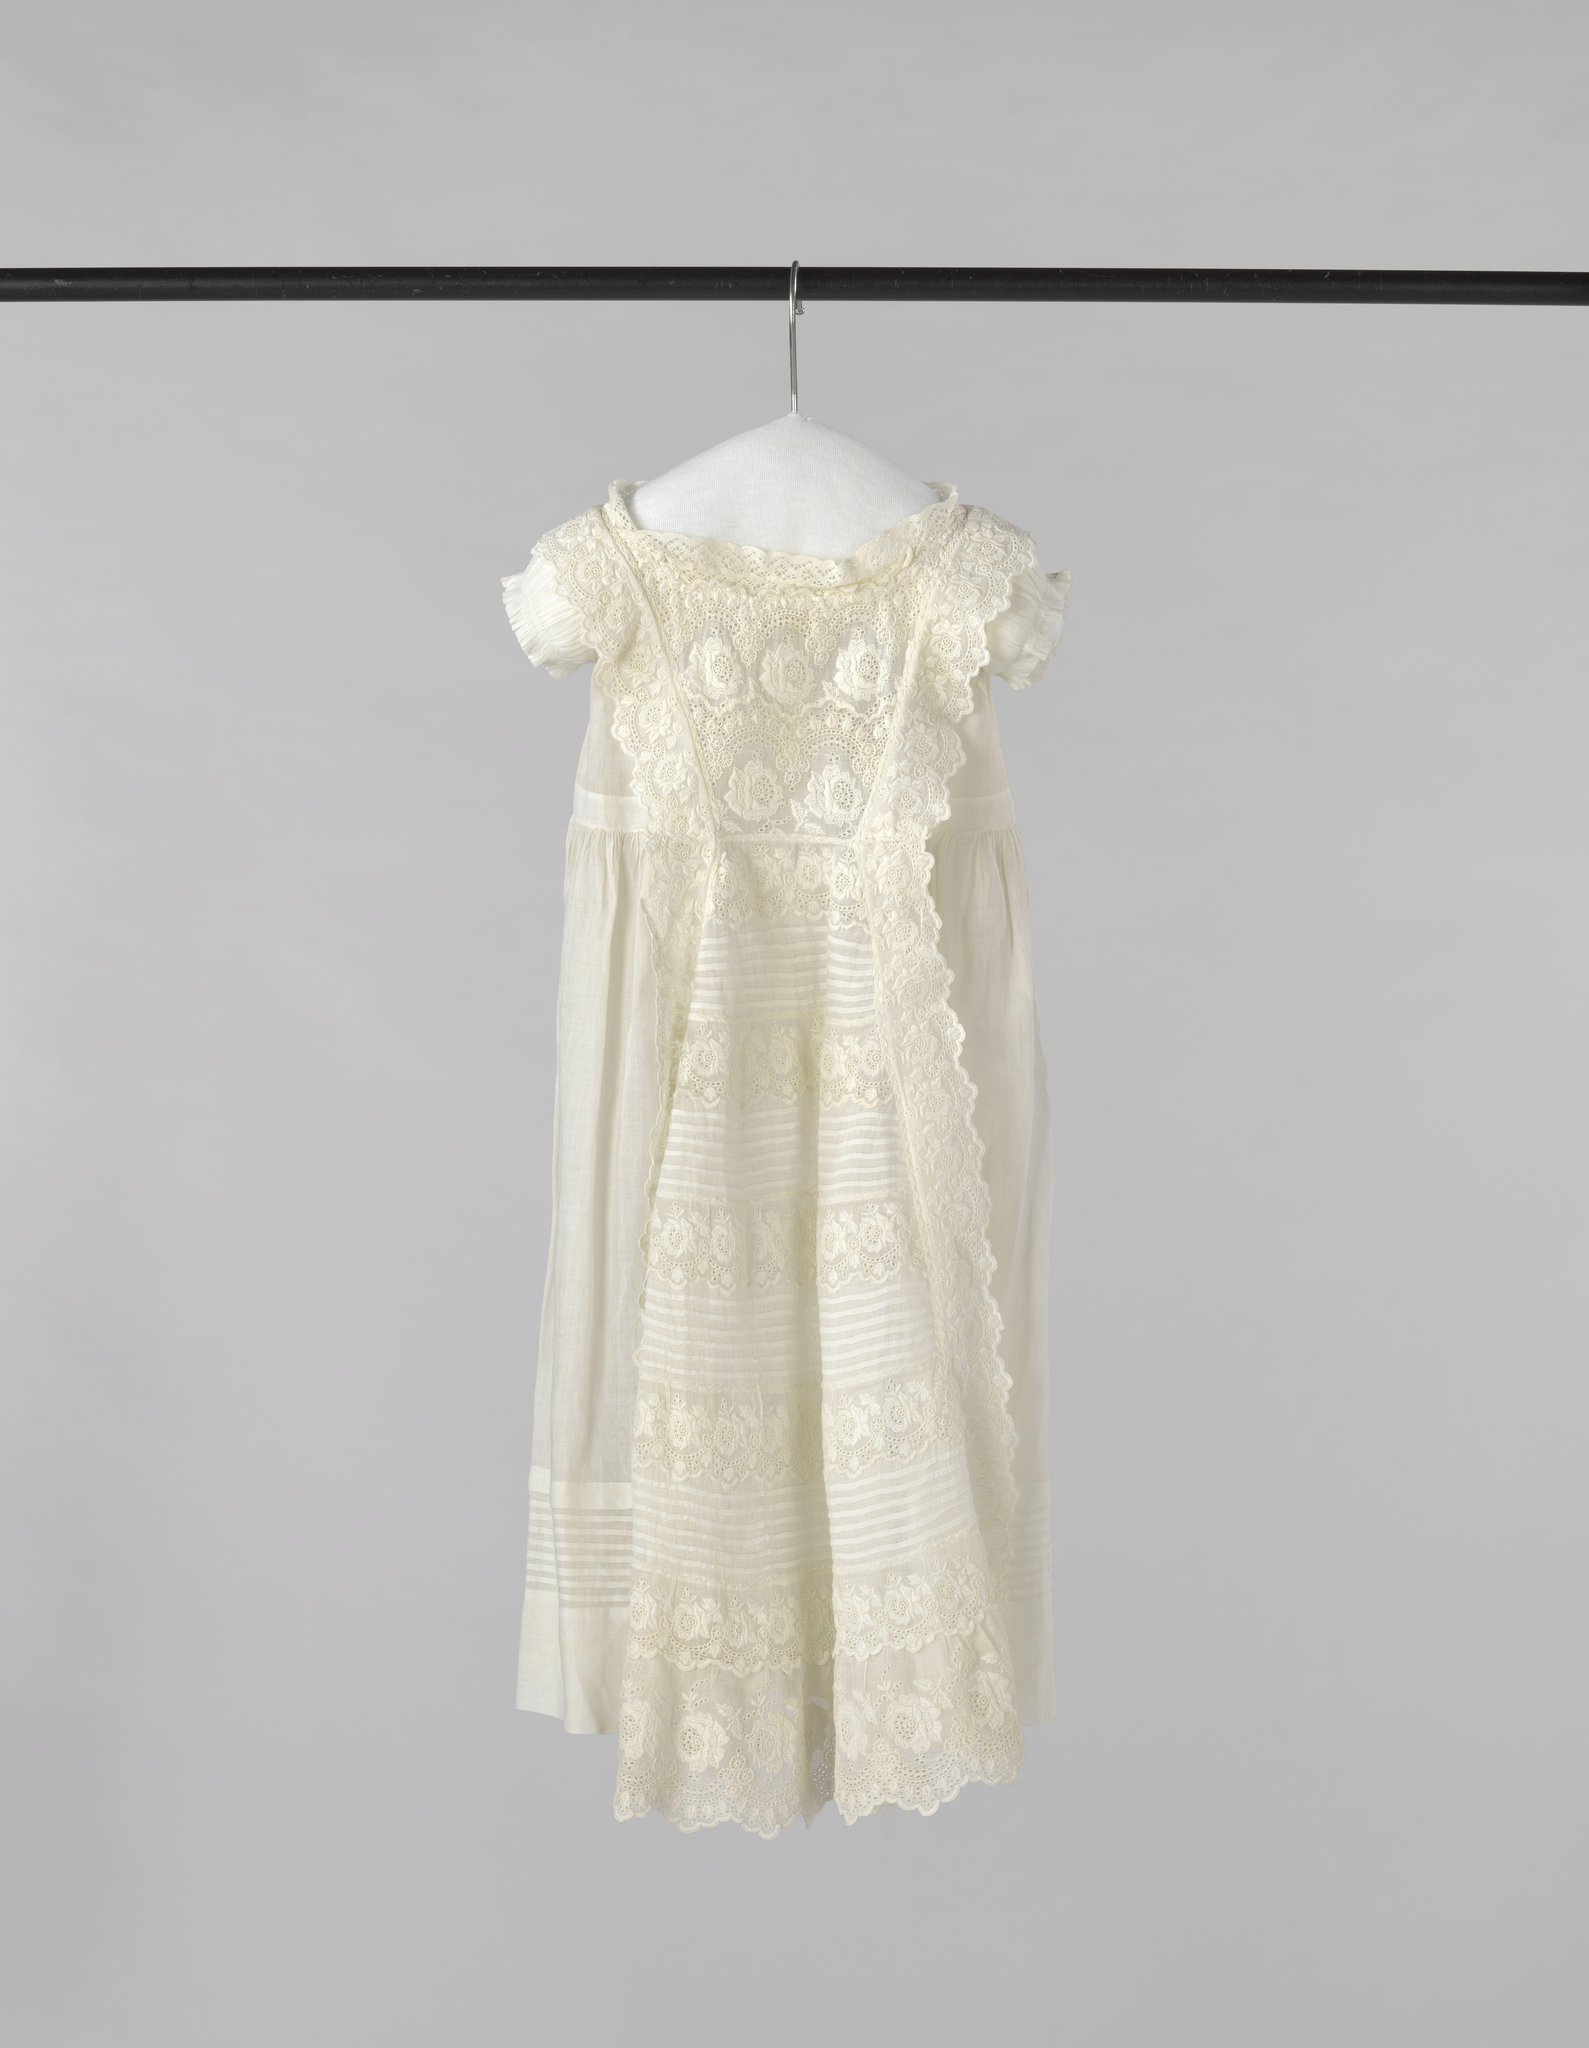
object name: robe, japon, jurk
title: Kleuterjurk van batist met glad ingezette schulpstrookjes met rozenborduursel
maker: Anonymous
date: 1850-1870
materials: textile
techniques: embroidered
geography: switzerland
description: Een kleuterjurk van batist met glad ingezette schulpstrookjes met rozenborduursel. Victoriaans.